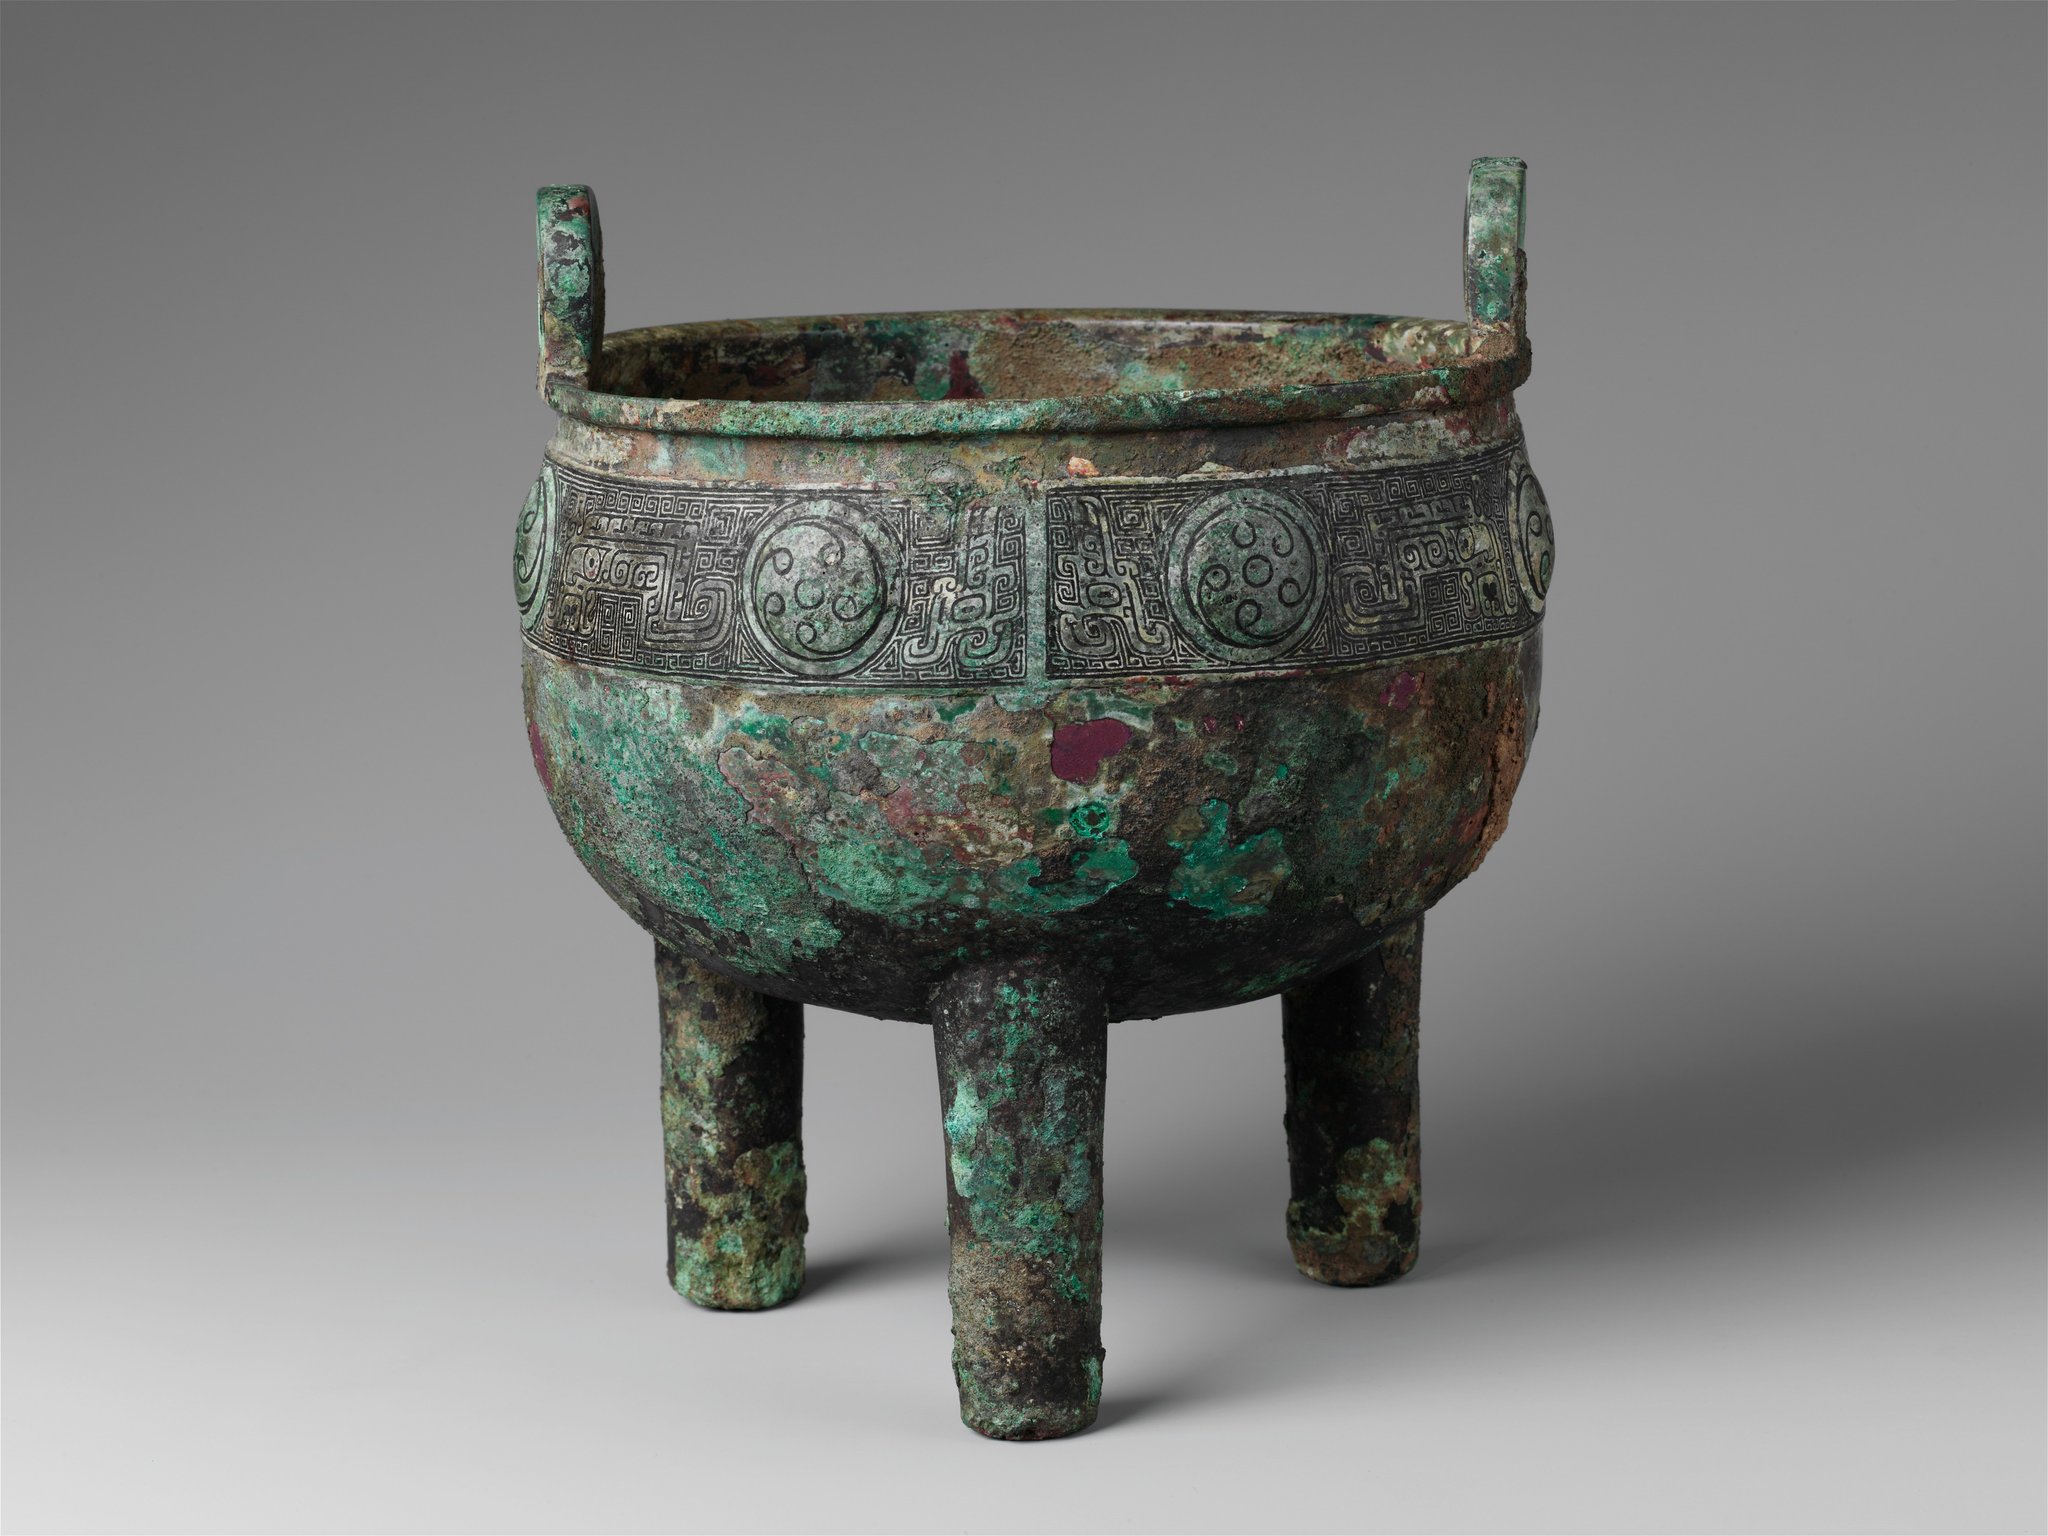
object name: cauldron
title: Tripod cauldron (Ding)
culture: chinese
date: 1300-1101 BCE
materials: bronze